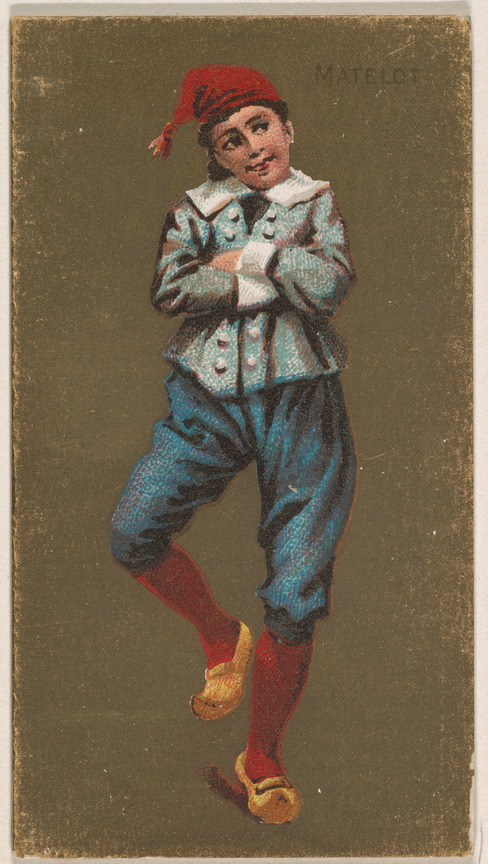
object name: print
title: Matelot, from National Dances (N225, Type 2) issued by Kinney Bros.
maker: kinney brothers tobacco company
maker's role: publisher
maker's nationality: american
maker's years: 1869-2011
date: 1889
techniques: color lithograph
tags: women,dancing,dancers